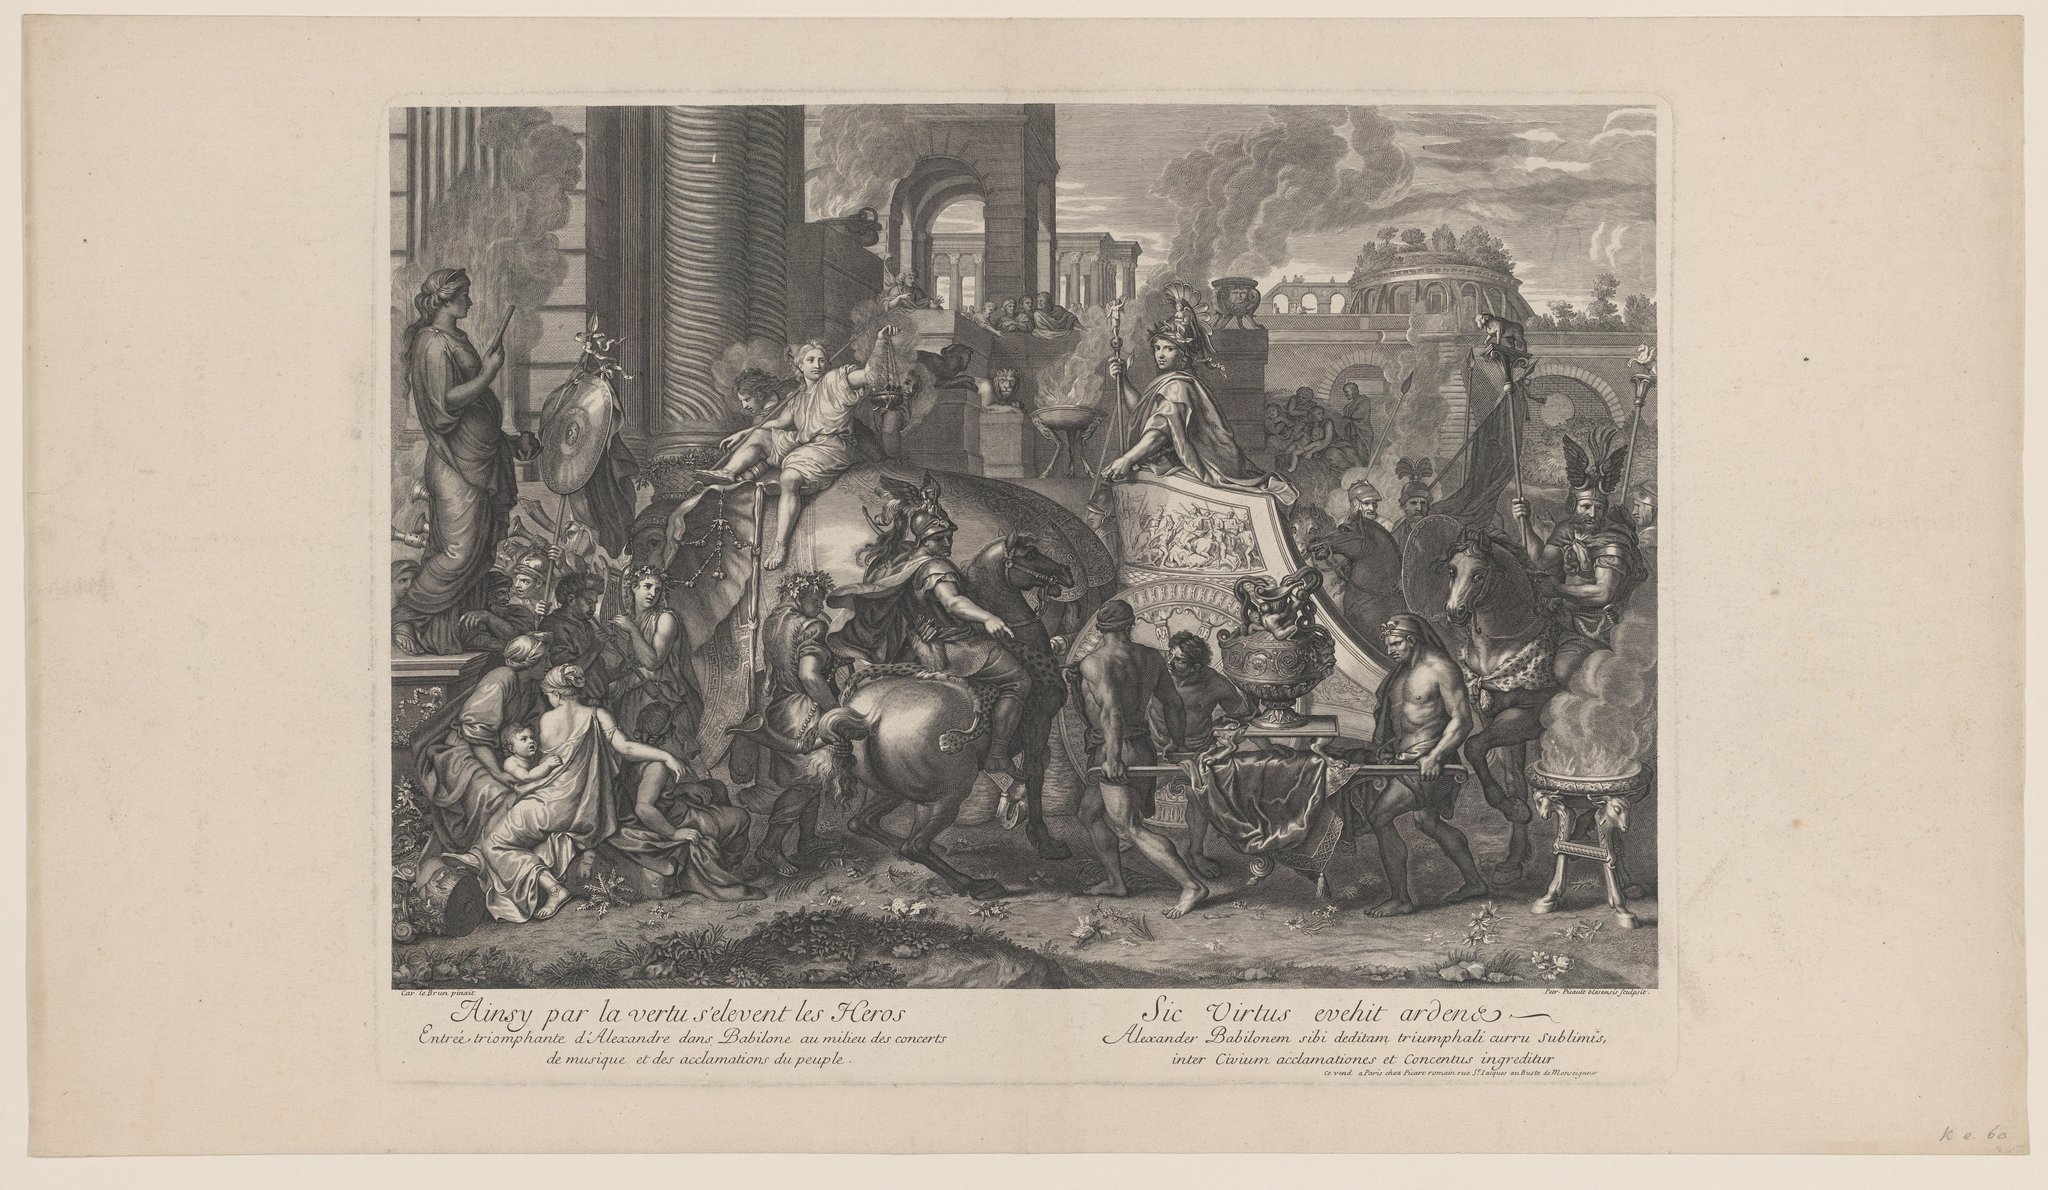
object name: print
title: Ainsy par la vertu s'elevent les Heros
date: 1690-1711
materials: paper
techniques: engraving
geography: paris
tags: (story of) alexander the great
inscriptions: collector's mark: Lugt 240